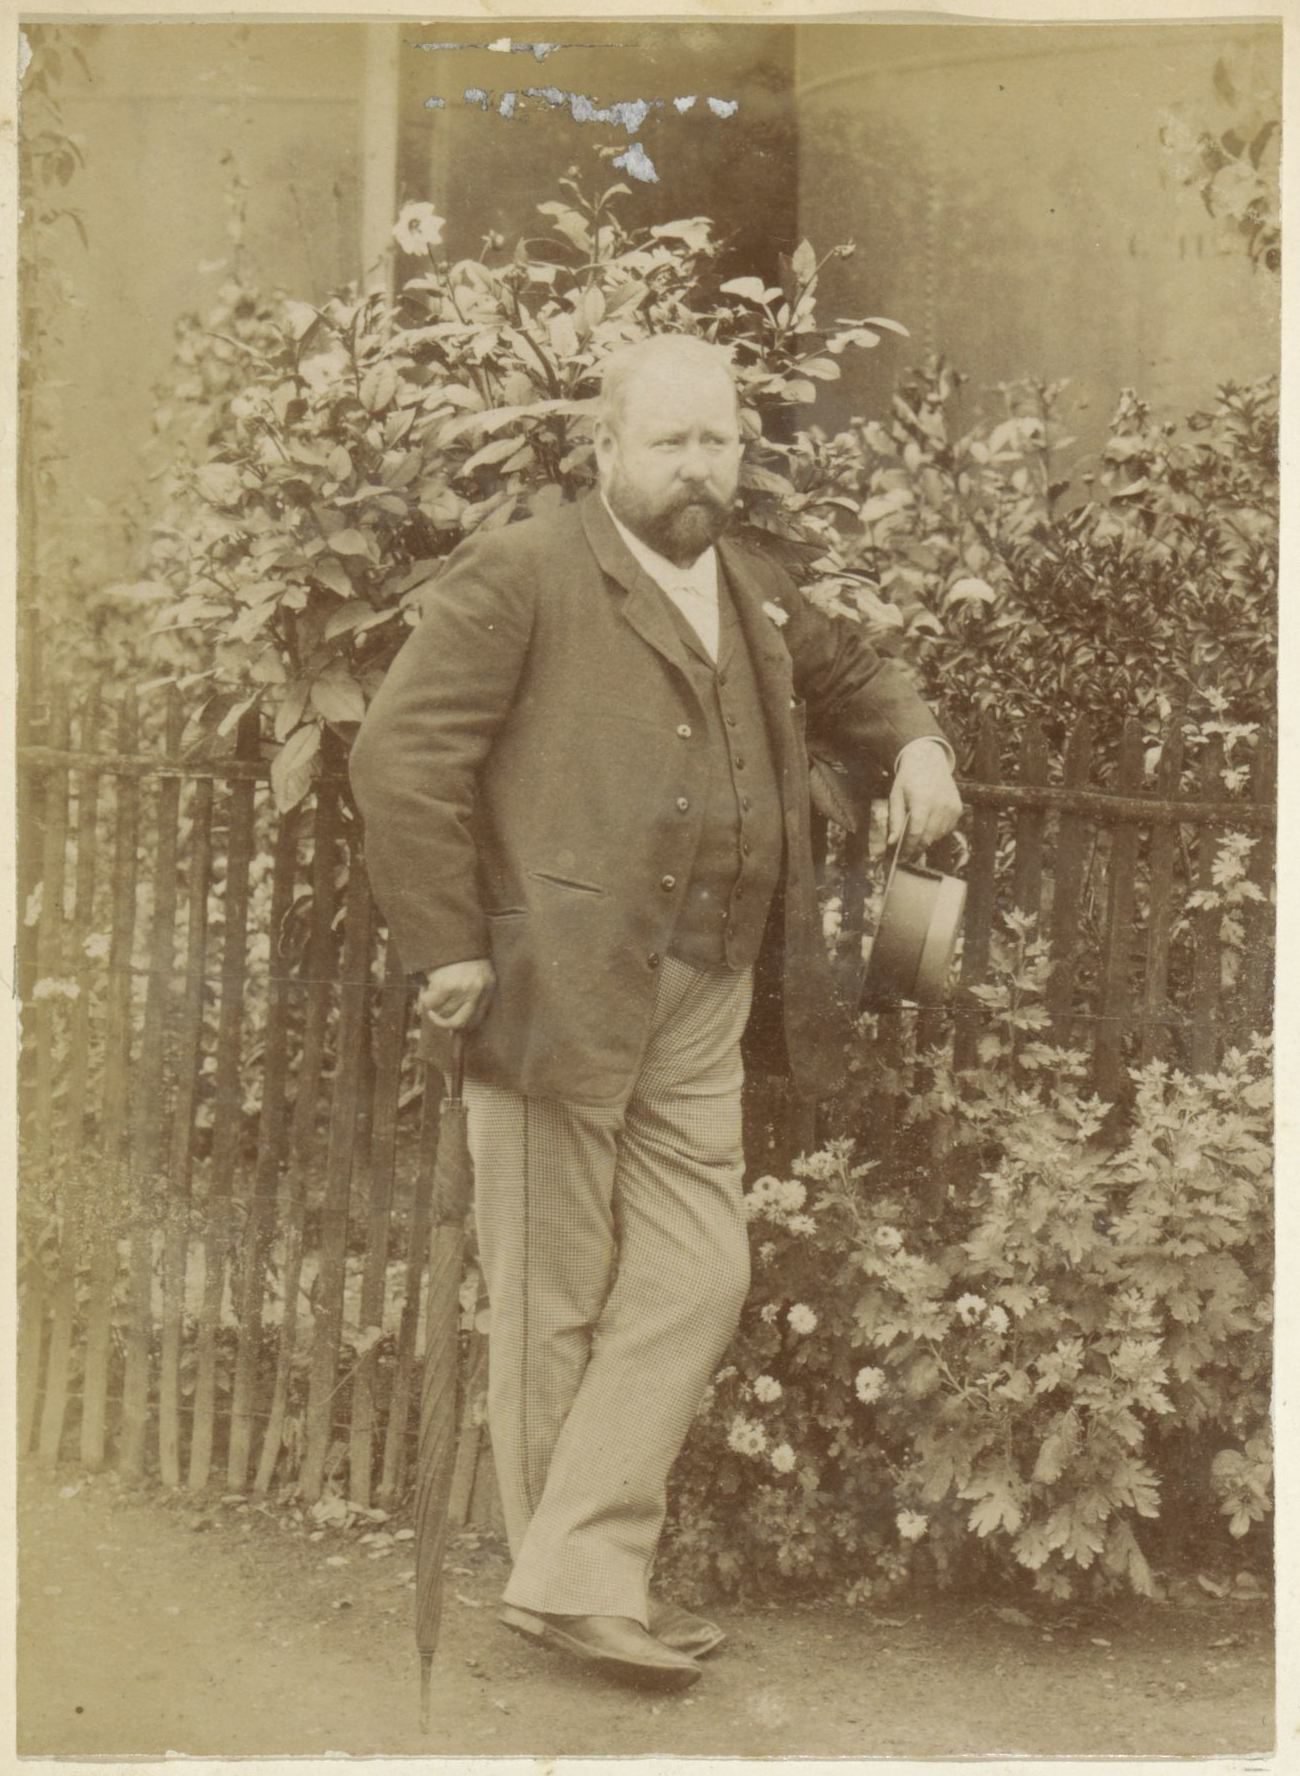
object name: photograph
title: Portret van een man met paraplu en hoed in de hand, staand bij een hek in Frankrijk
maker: Anonymous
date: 1900-1910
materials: paper, photographic support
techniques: albumen print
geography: france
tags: fence, wall, paling, adult man, head-gear: hat, umbrella, france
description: Onderdeel van Fotoalbum van een Franse amateurfotograaf met opnames van een familie, distilleerderij Delizy & Doistau Fils, het leger en bezienswaardigheden in Frankrijk.